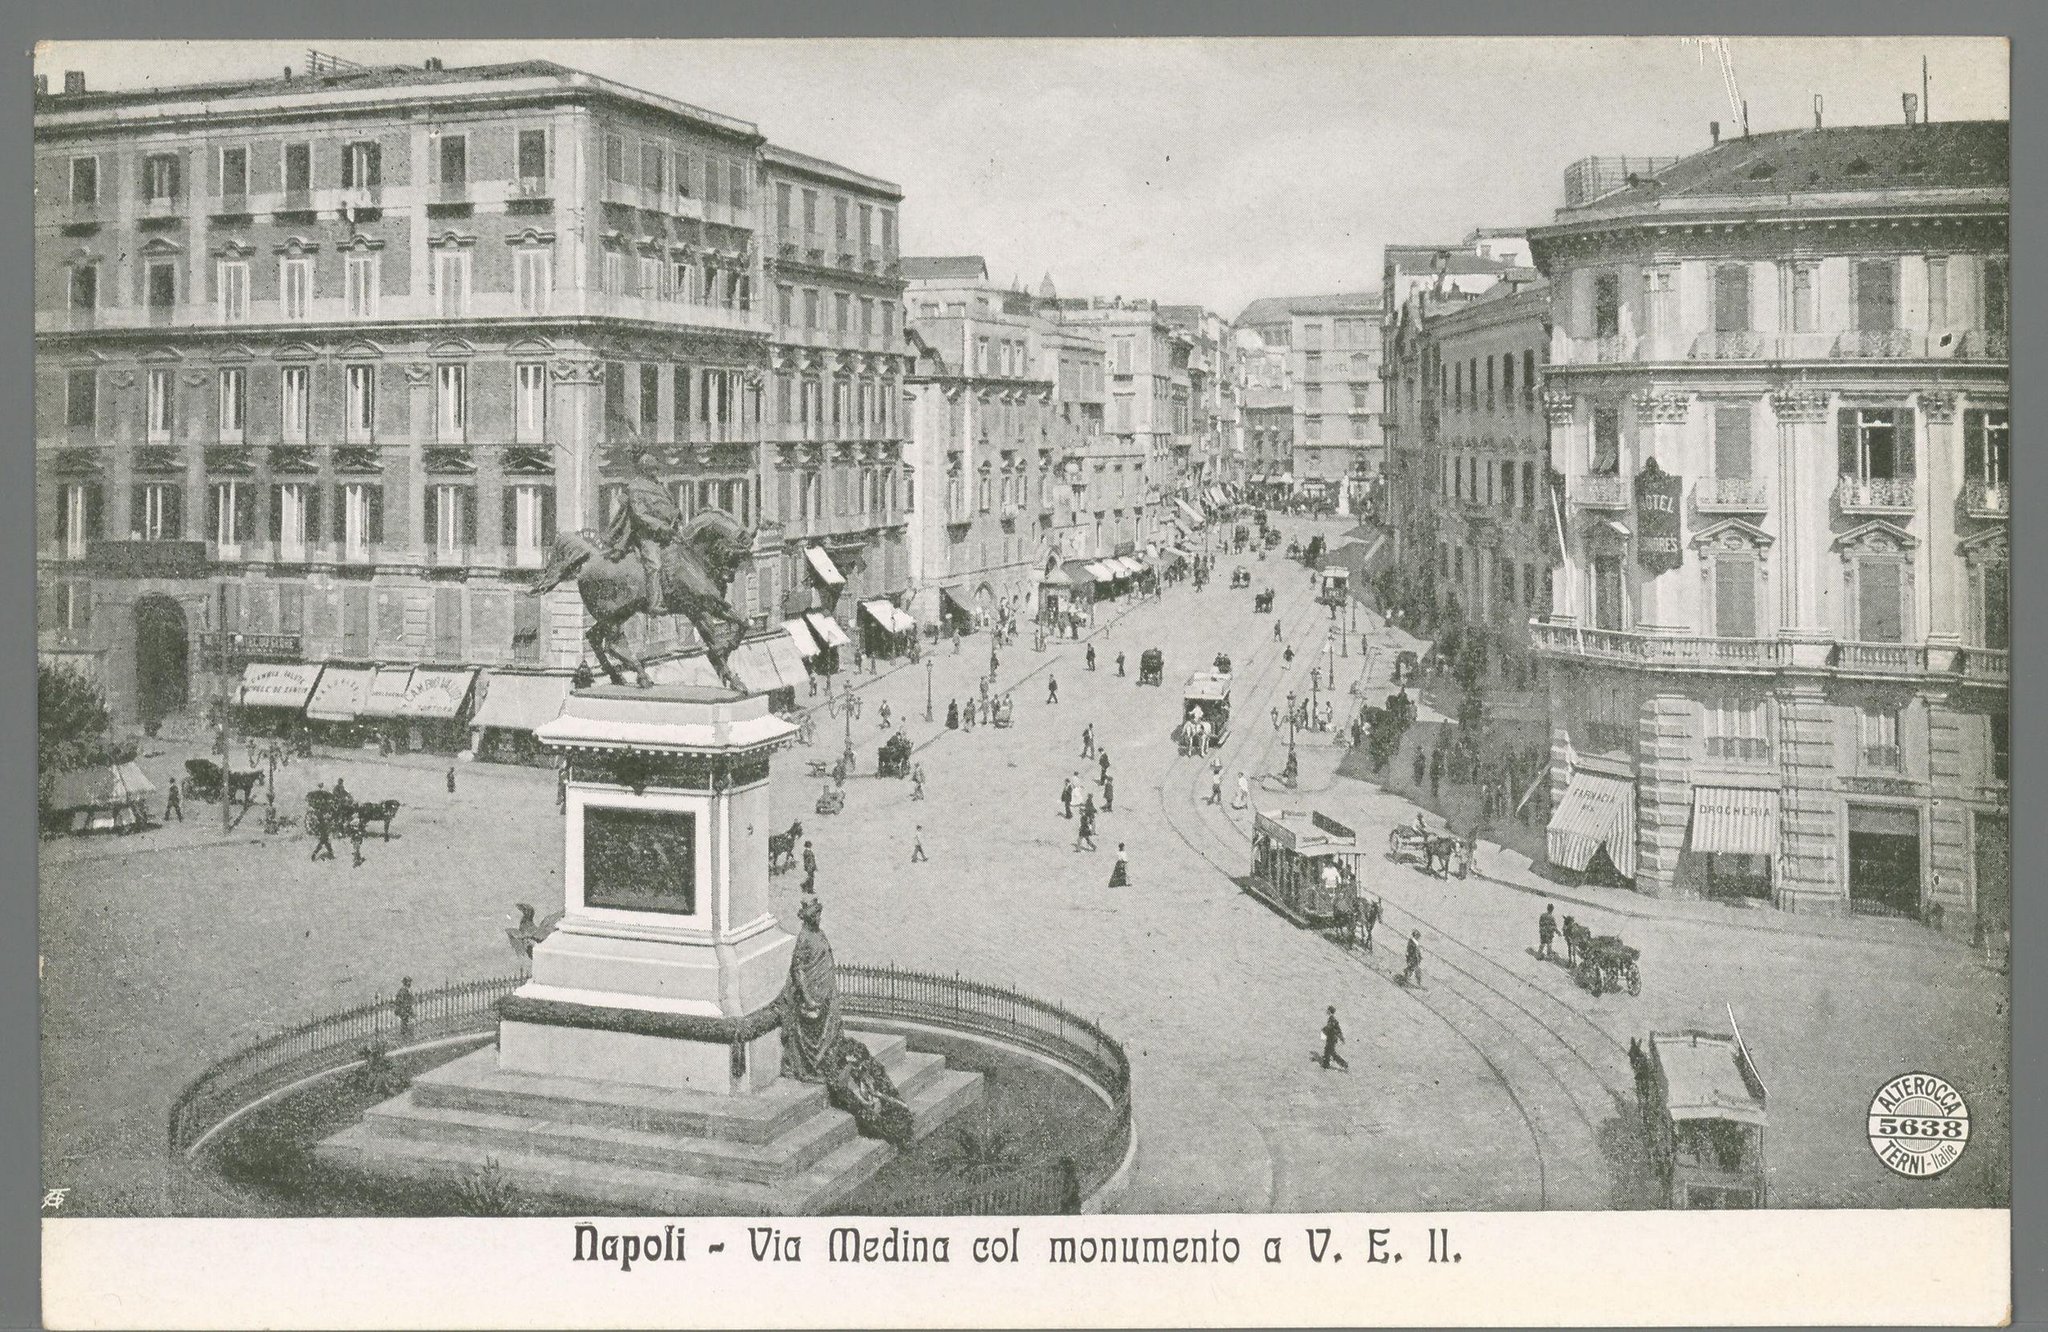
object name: ansichtkaart, prentbriefkaart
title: Napoli. Via Medina col monumento a V.E. II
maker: Anonymous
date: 1906-1910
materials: cardboard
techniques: autotype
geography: terni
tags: rome, monument, statue, square, place, circus, etc. (+ city(-scape) with figures, staffage), naples